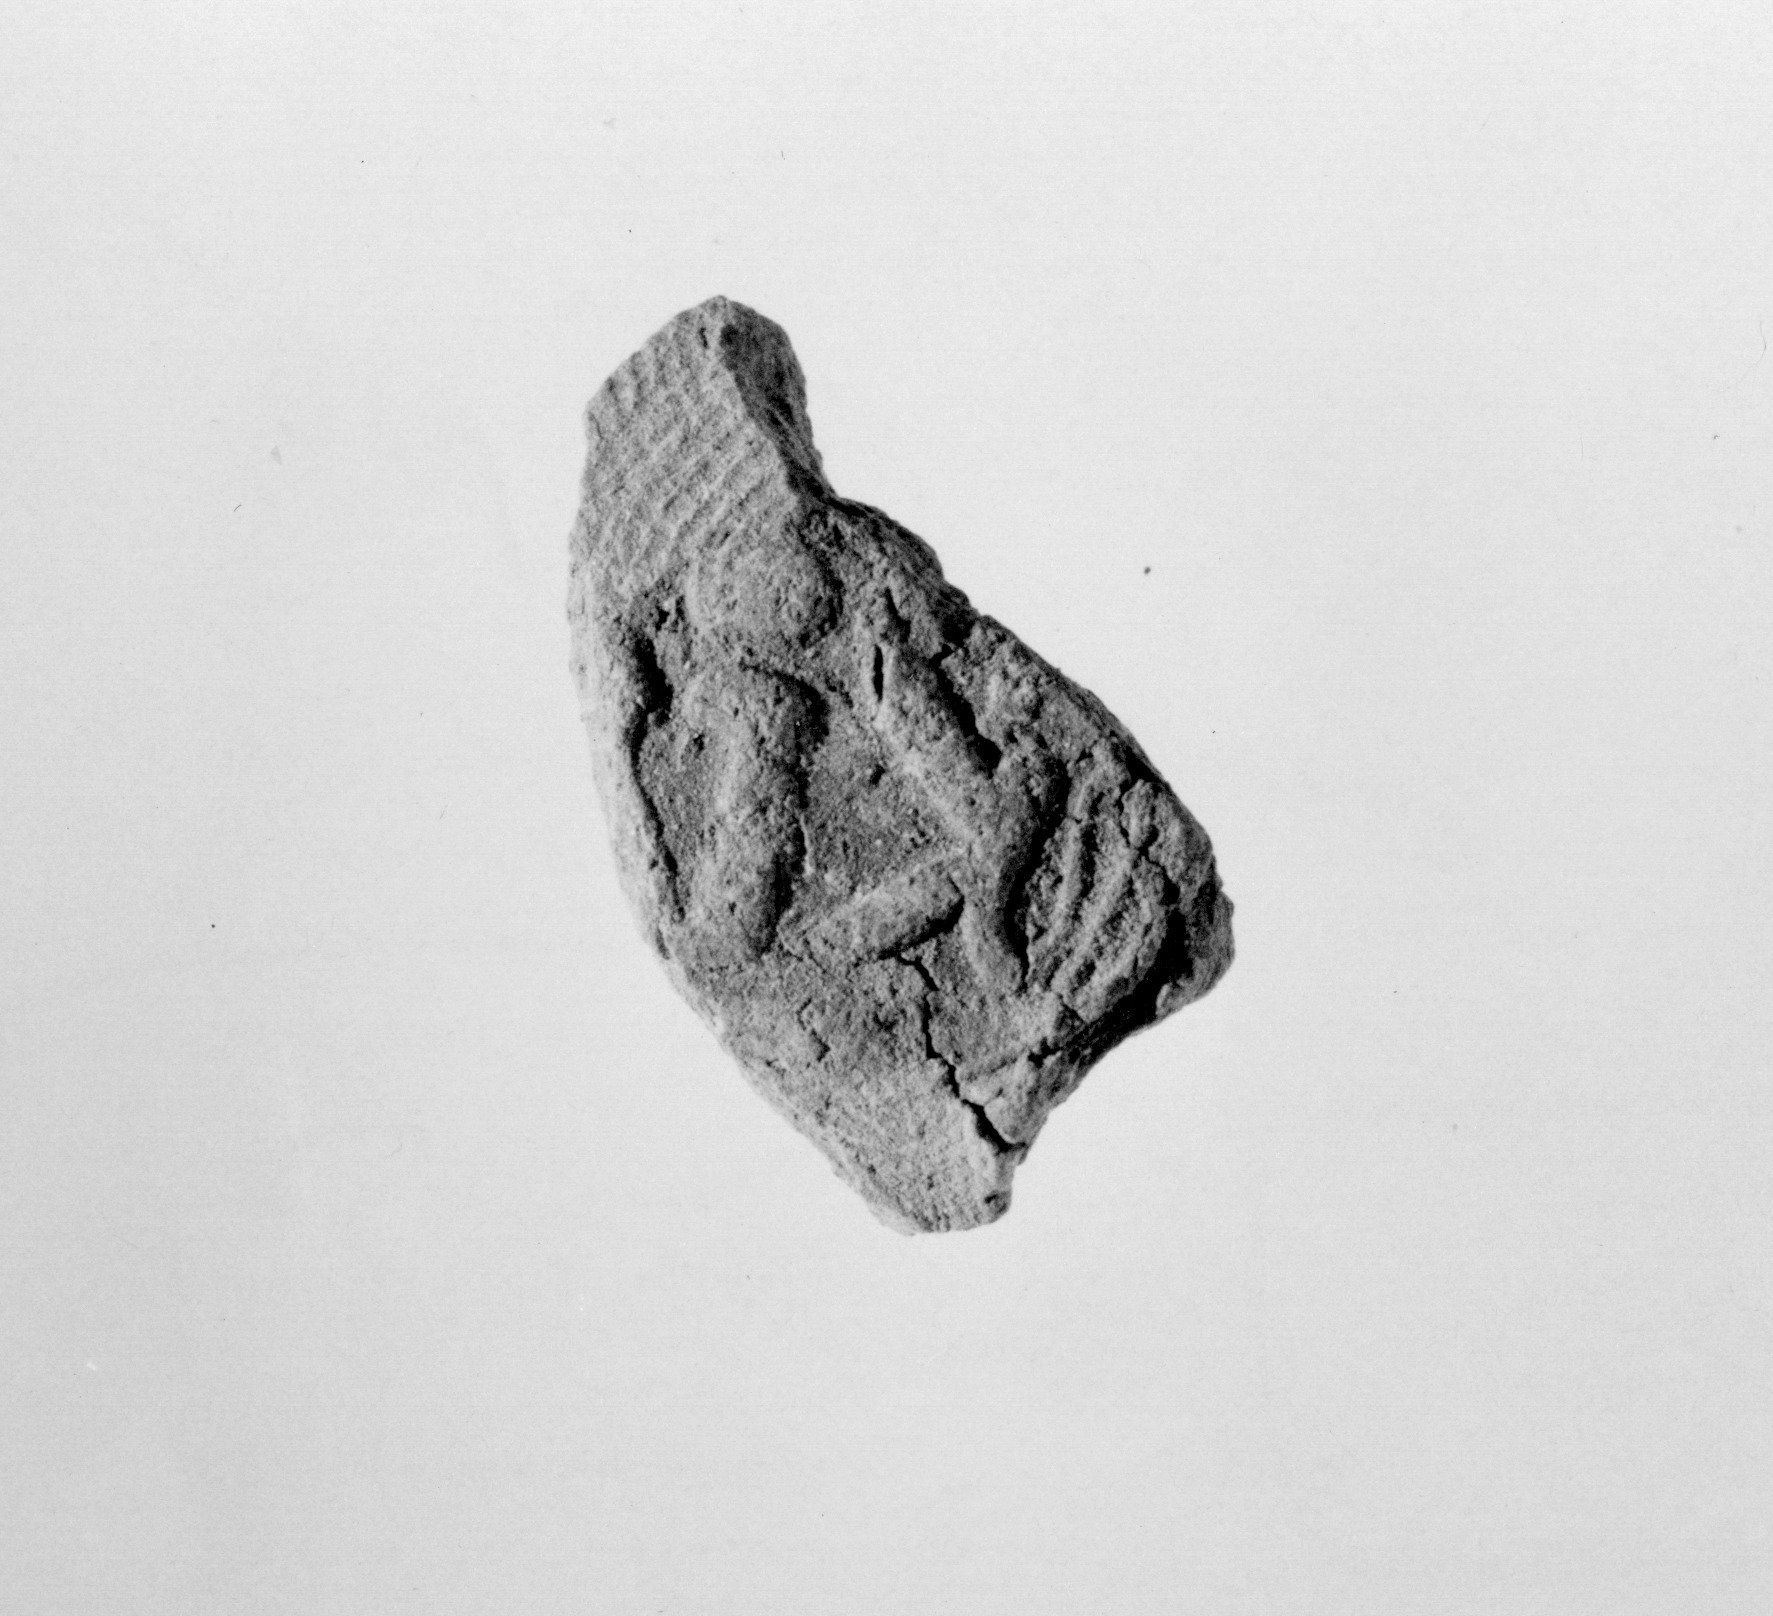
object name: sealing, nebmaatre, amenhotep iii,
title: Document Sealing With the Throne Name of Amenhotep III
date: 1390-1352 BCE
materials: mud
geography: egypt